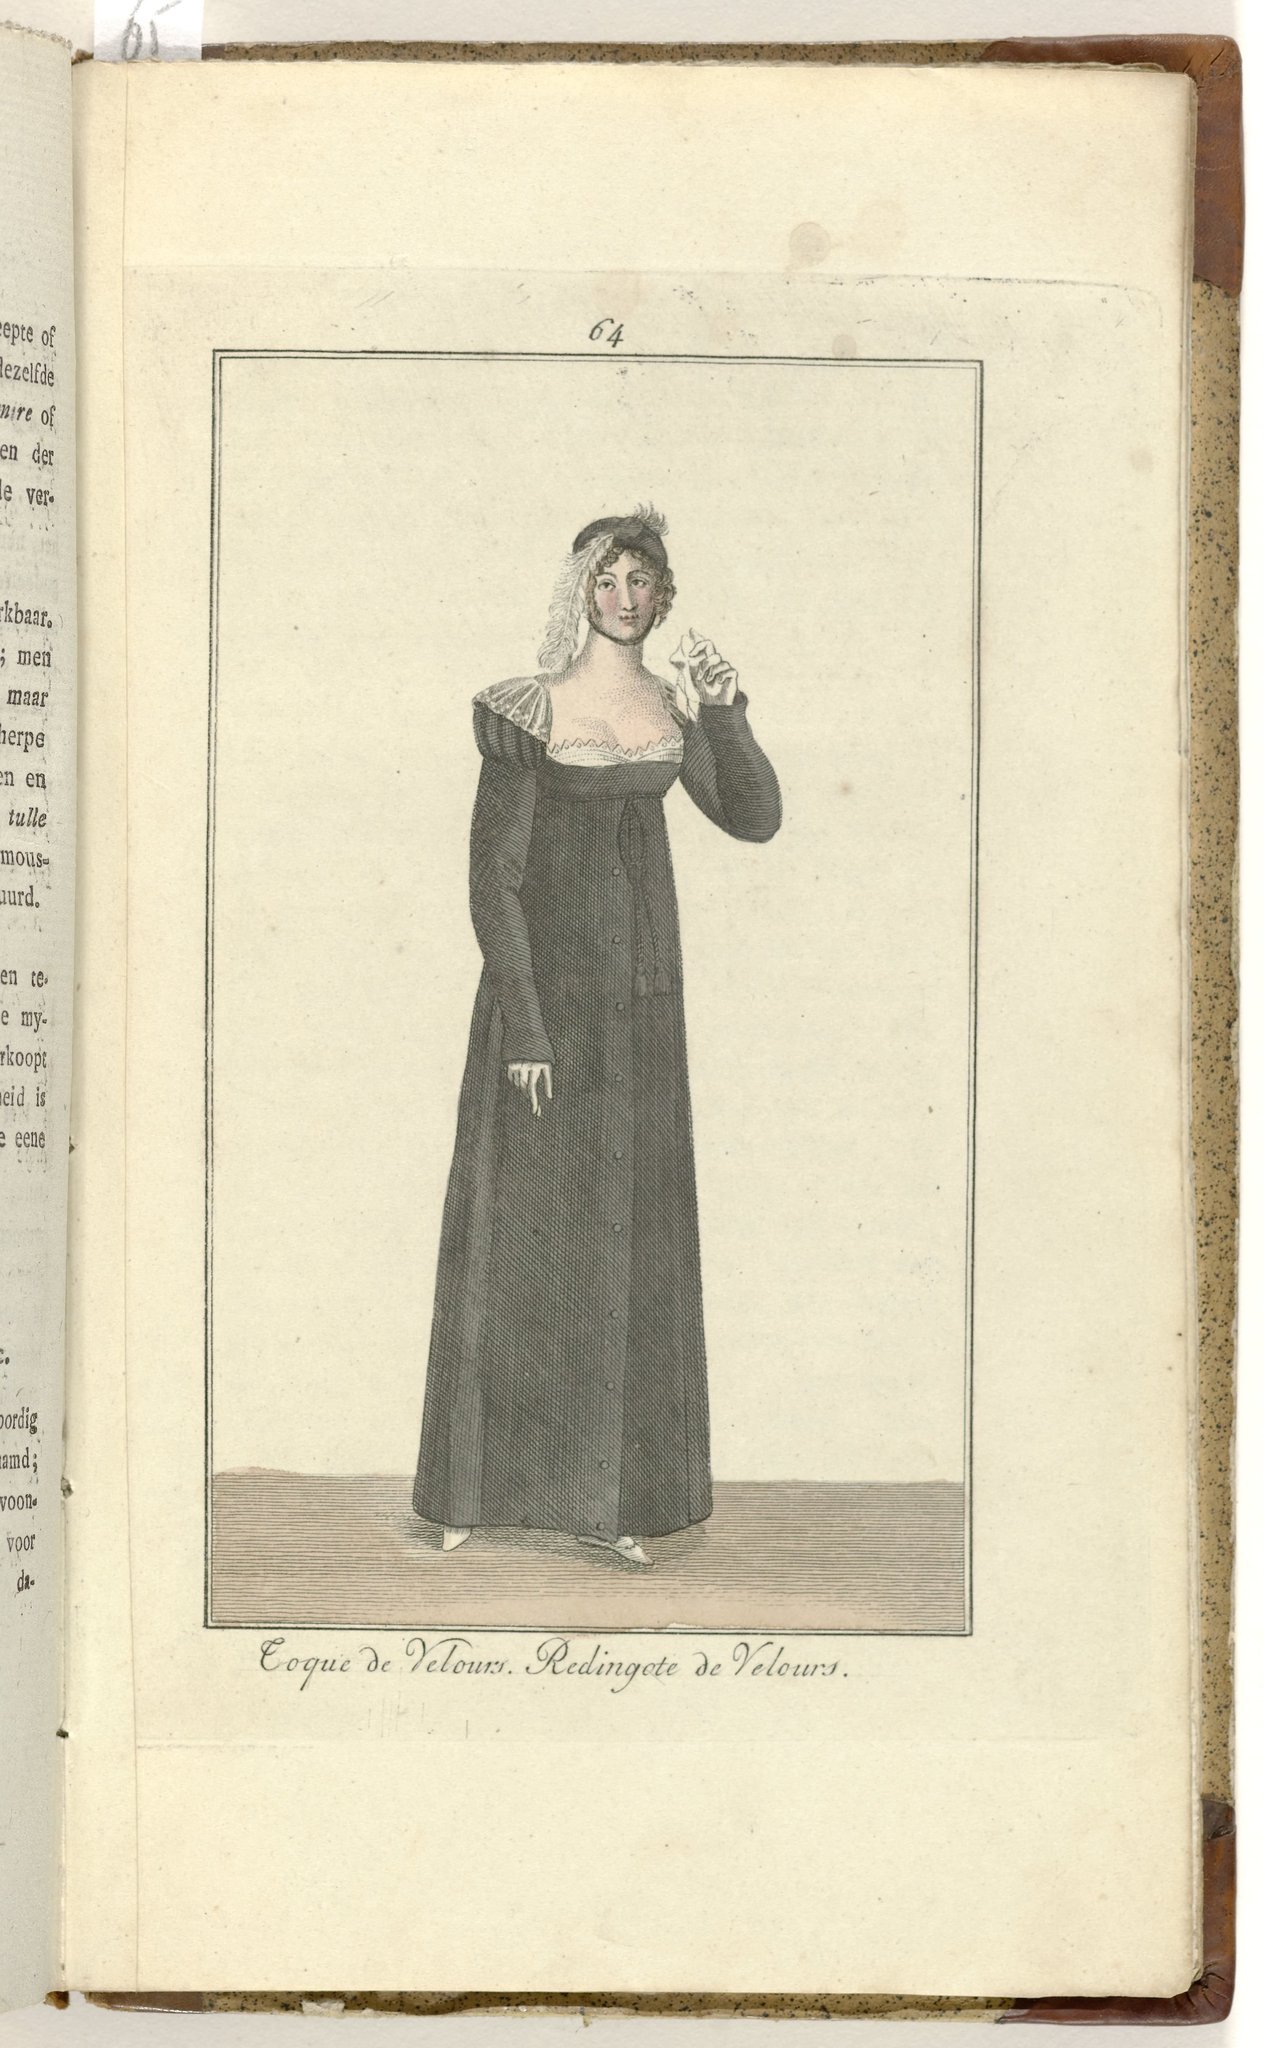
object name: magazine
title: Elegantia, of tijdschrift van mode, luxe en smaak voor dames, December 1808, No. 64: Toque de Velours...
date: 1808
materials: paper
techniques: engraving, hand coloring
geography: amsterdam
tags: handkerchief (+ women's clothes), head-gear: toque (+ women's clothes), dress, gown: redingote (+ women's clothes), fashion plates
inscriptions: caption: ‘Toque de Velours. Redingote de Velours.’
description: Volgens de begeleidende tekst (p. 384): Fluwelen 'redingote'. Toque van dezelfde stof en kleur (zwart of donkerblauw). Prent uit het modetijdschrift Elegantia, of tijdschrift van mode, luxe en smaak voor dames 1807-1814 (onderbroken door de periode 1811-1813).